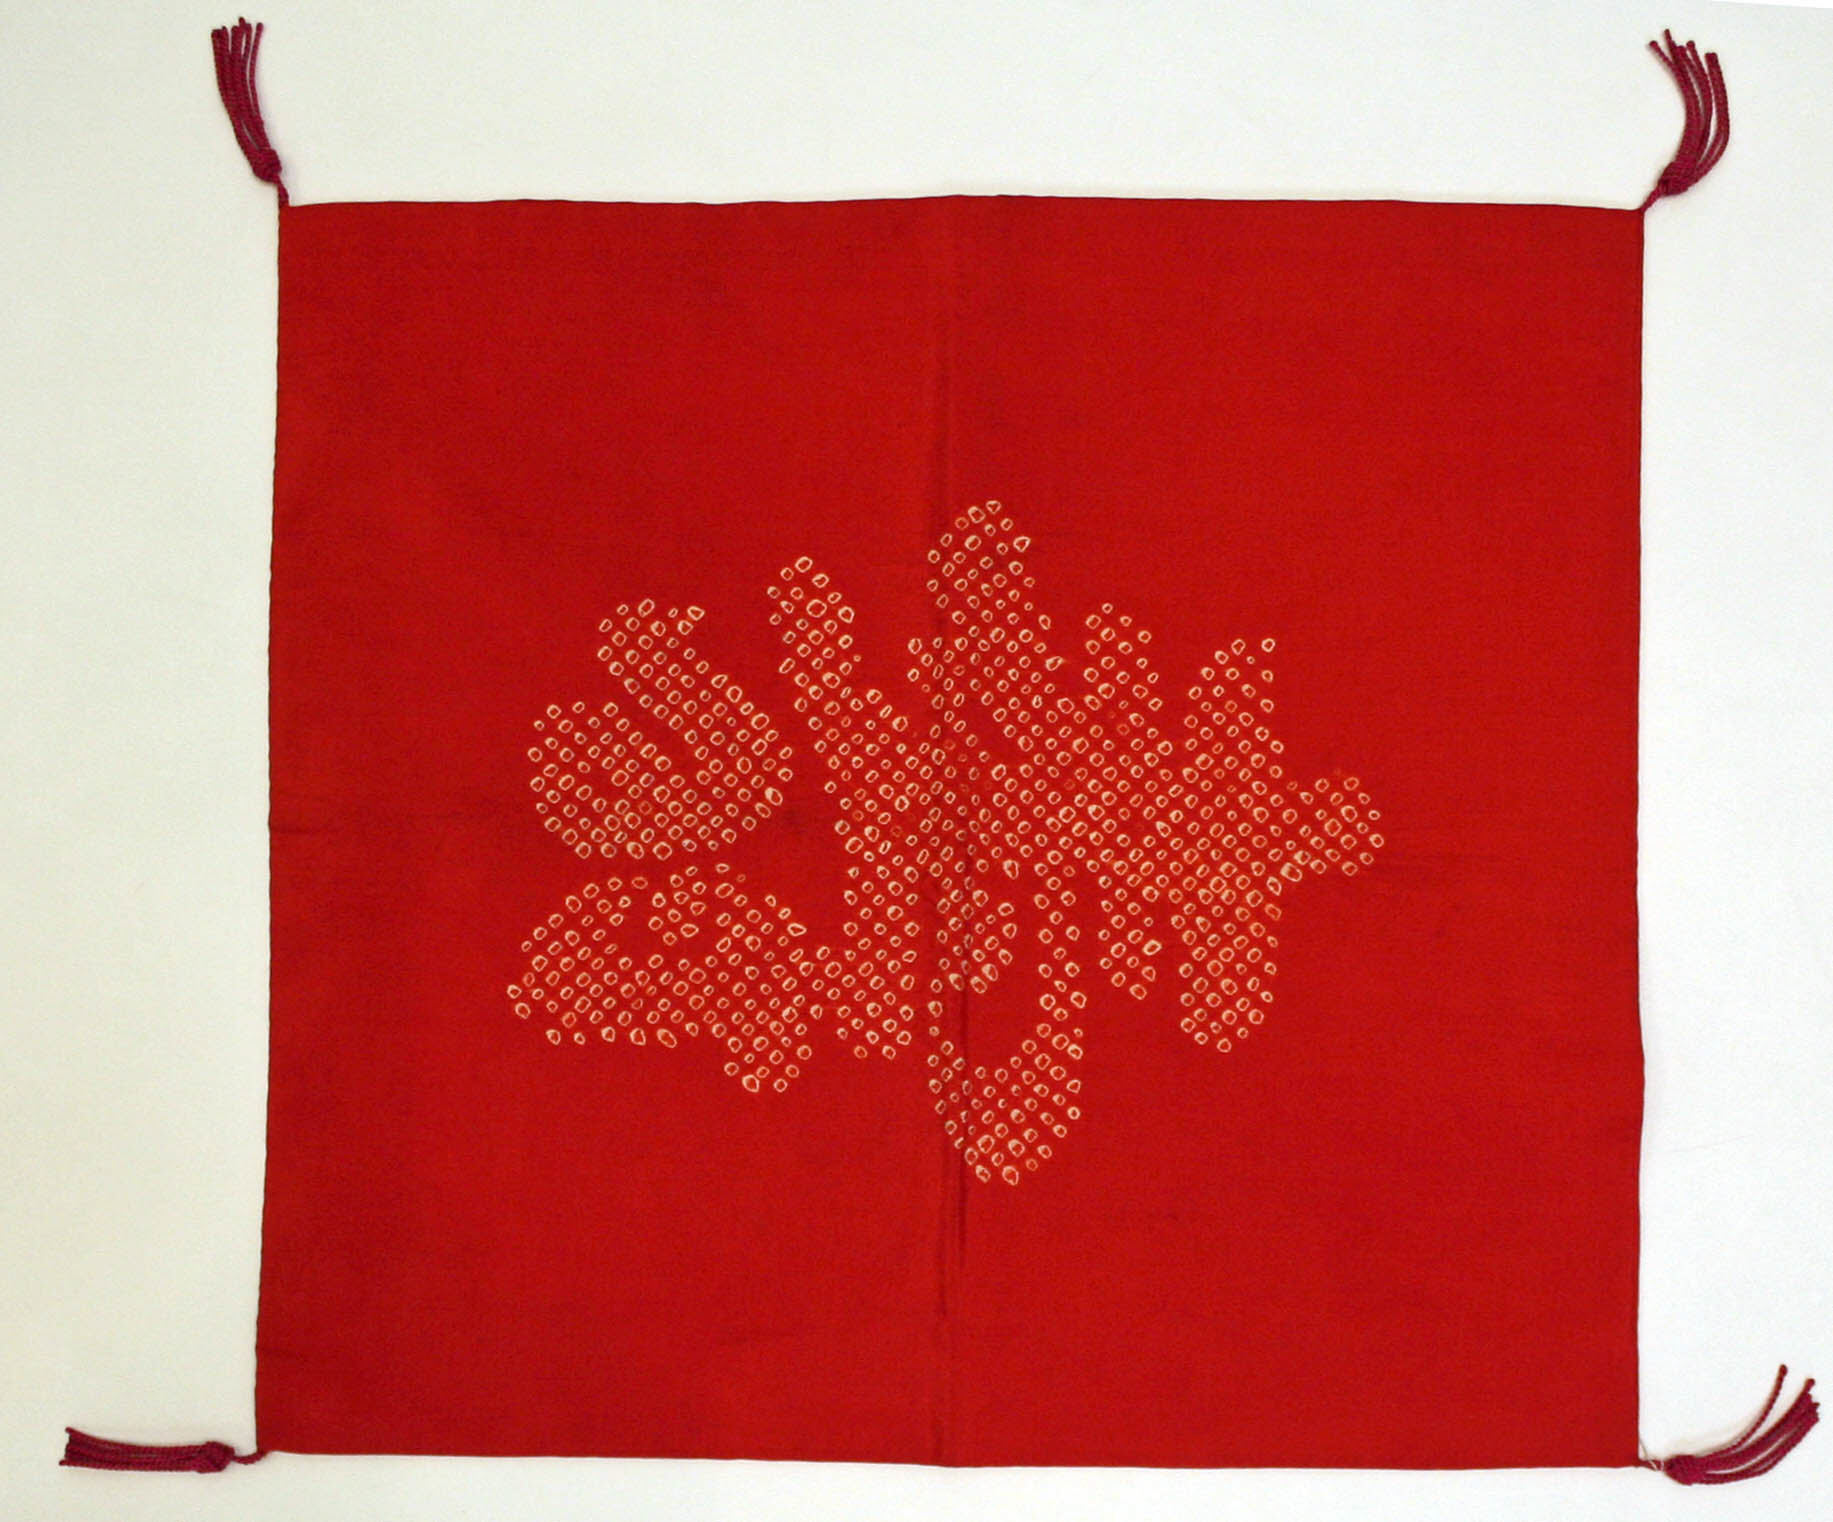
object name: textile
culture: japanese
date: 1800-1942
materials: silk